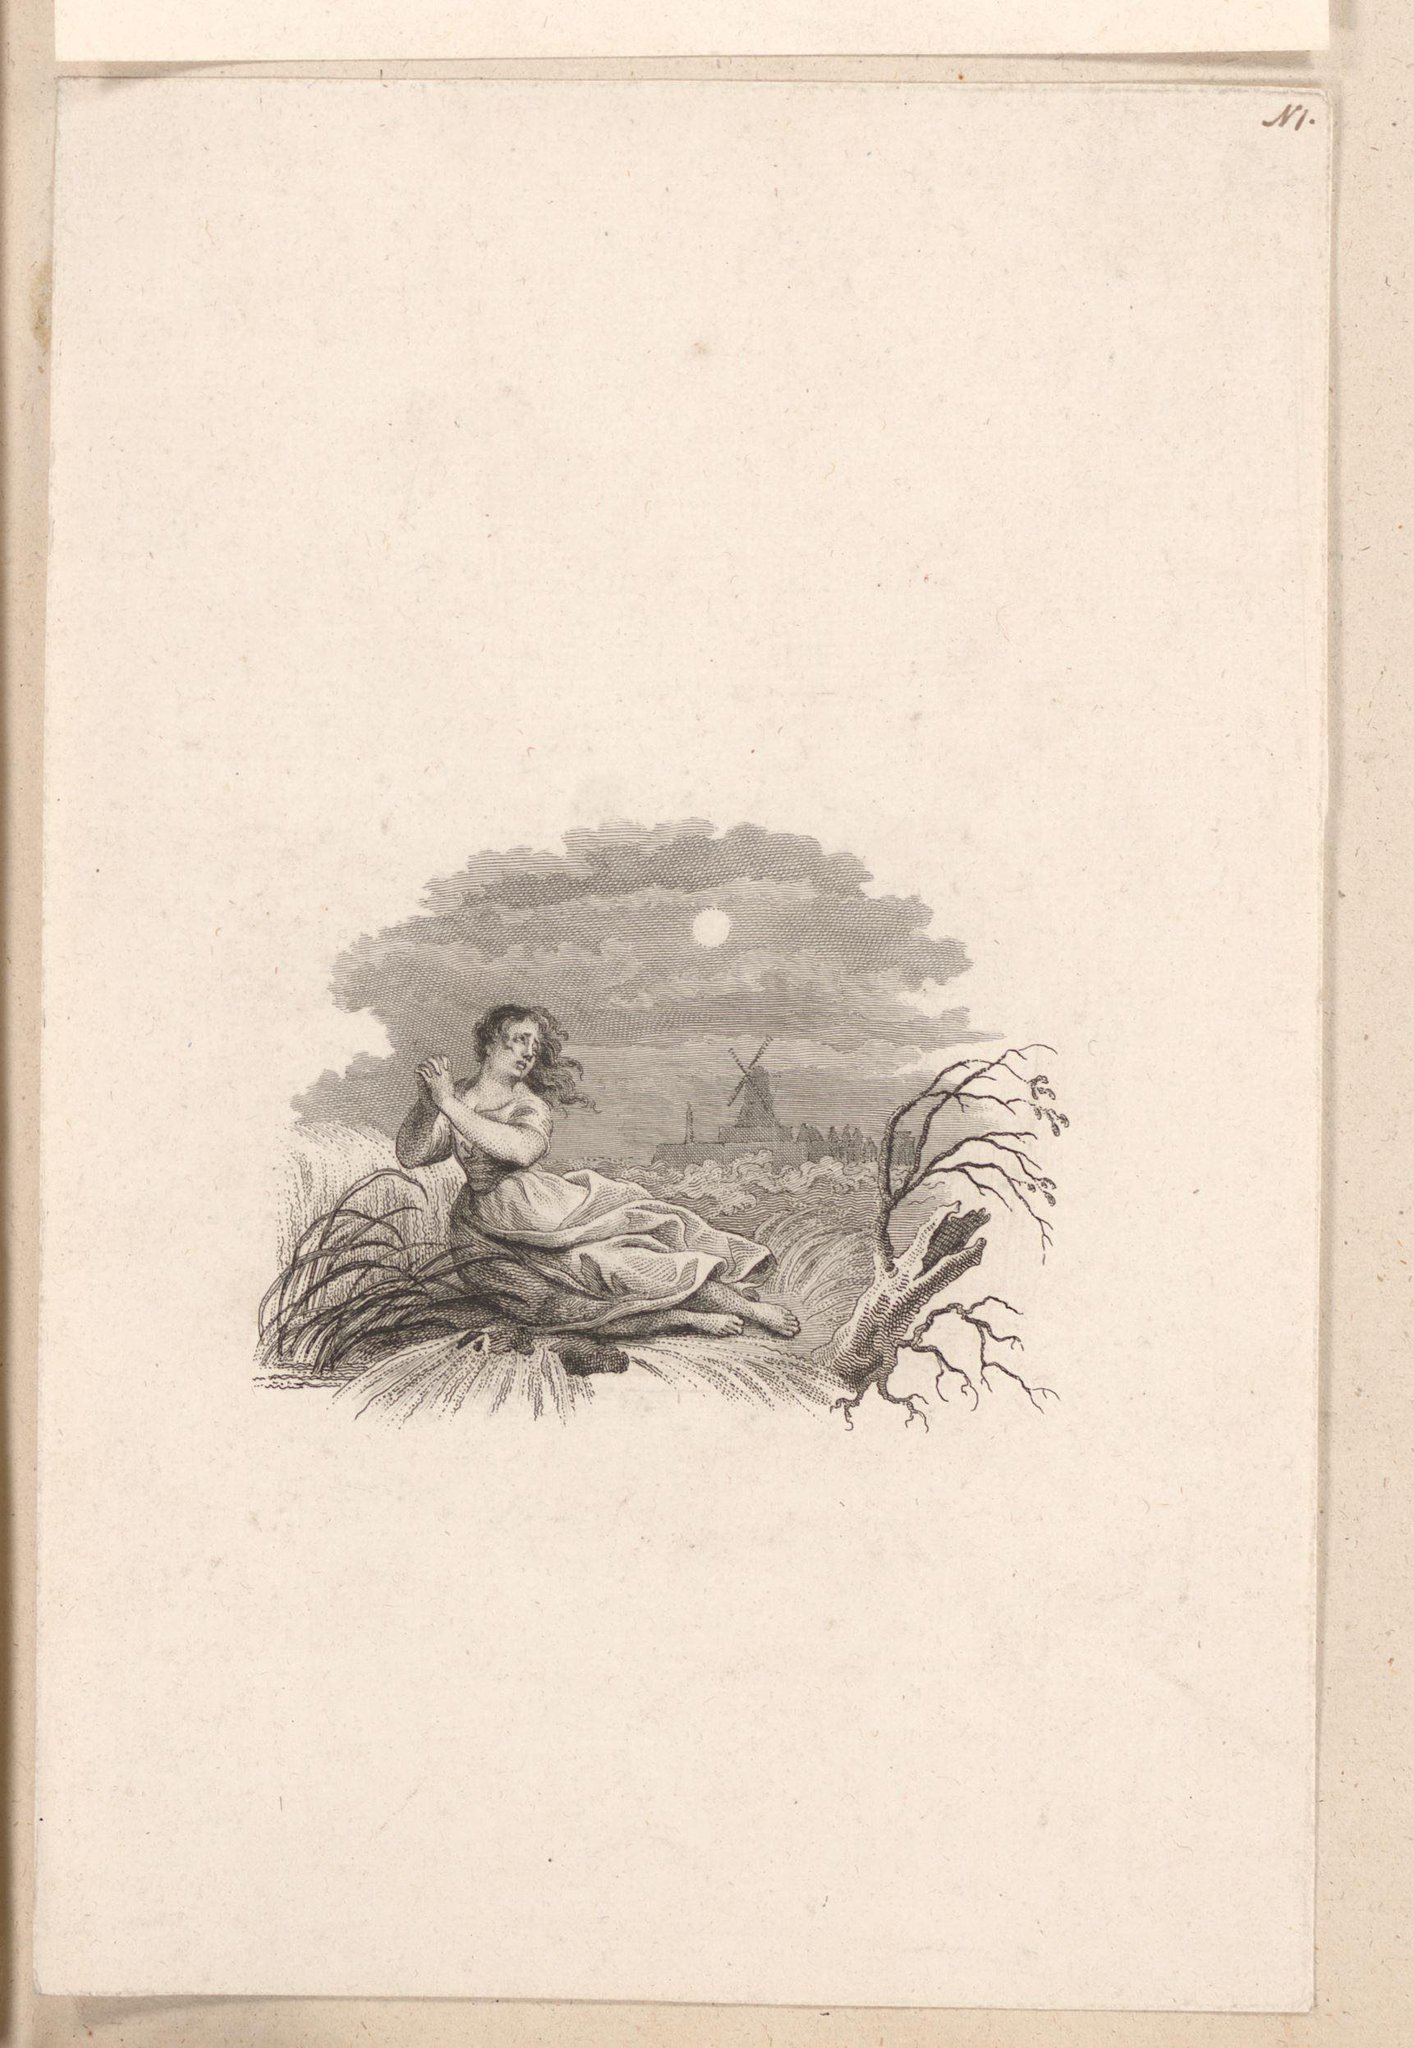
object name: print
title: Smekende vrouw bij nacht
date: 1771-1818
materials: paper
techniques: engraving, etching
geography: haarlem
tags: night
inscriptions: inscription: ‘N1’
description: Een korenveld met een treurige vrouw. Ze heeft haar handen gevouwen en kijkt naar de maan. Op de achtergrond een molen. De prent maakt deel uit van een album.